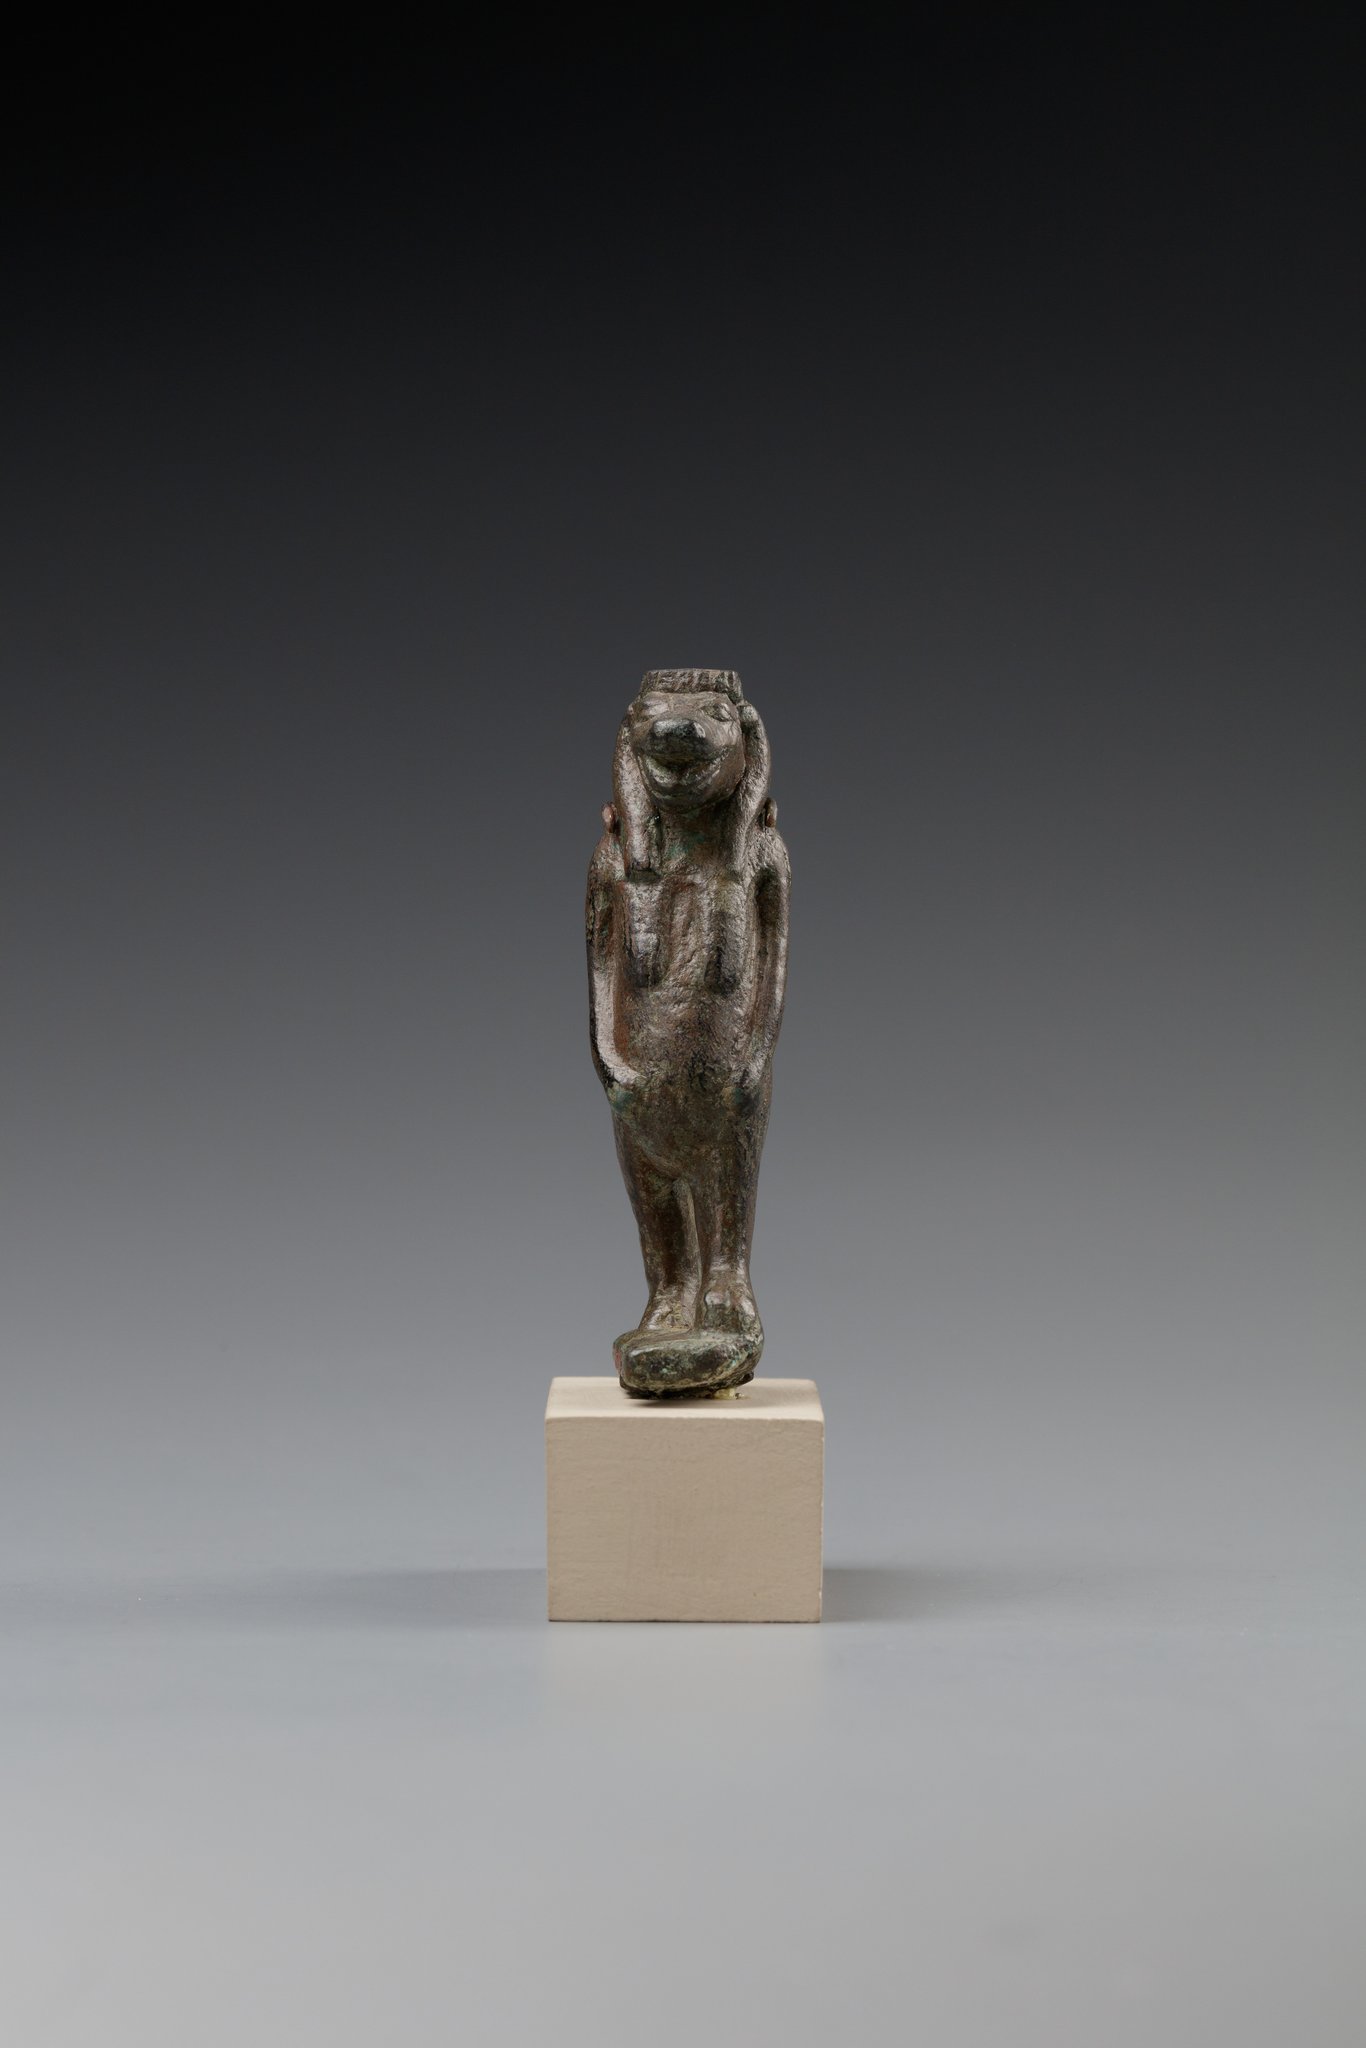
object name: amulet, taweret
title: Taweret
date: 664-630 BCE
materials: alloy, bronze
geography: egypt